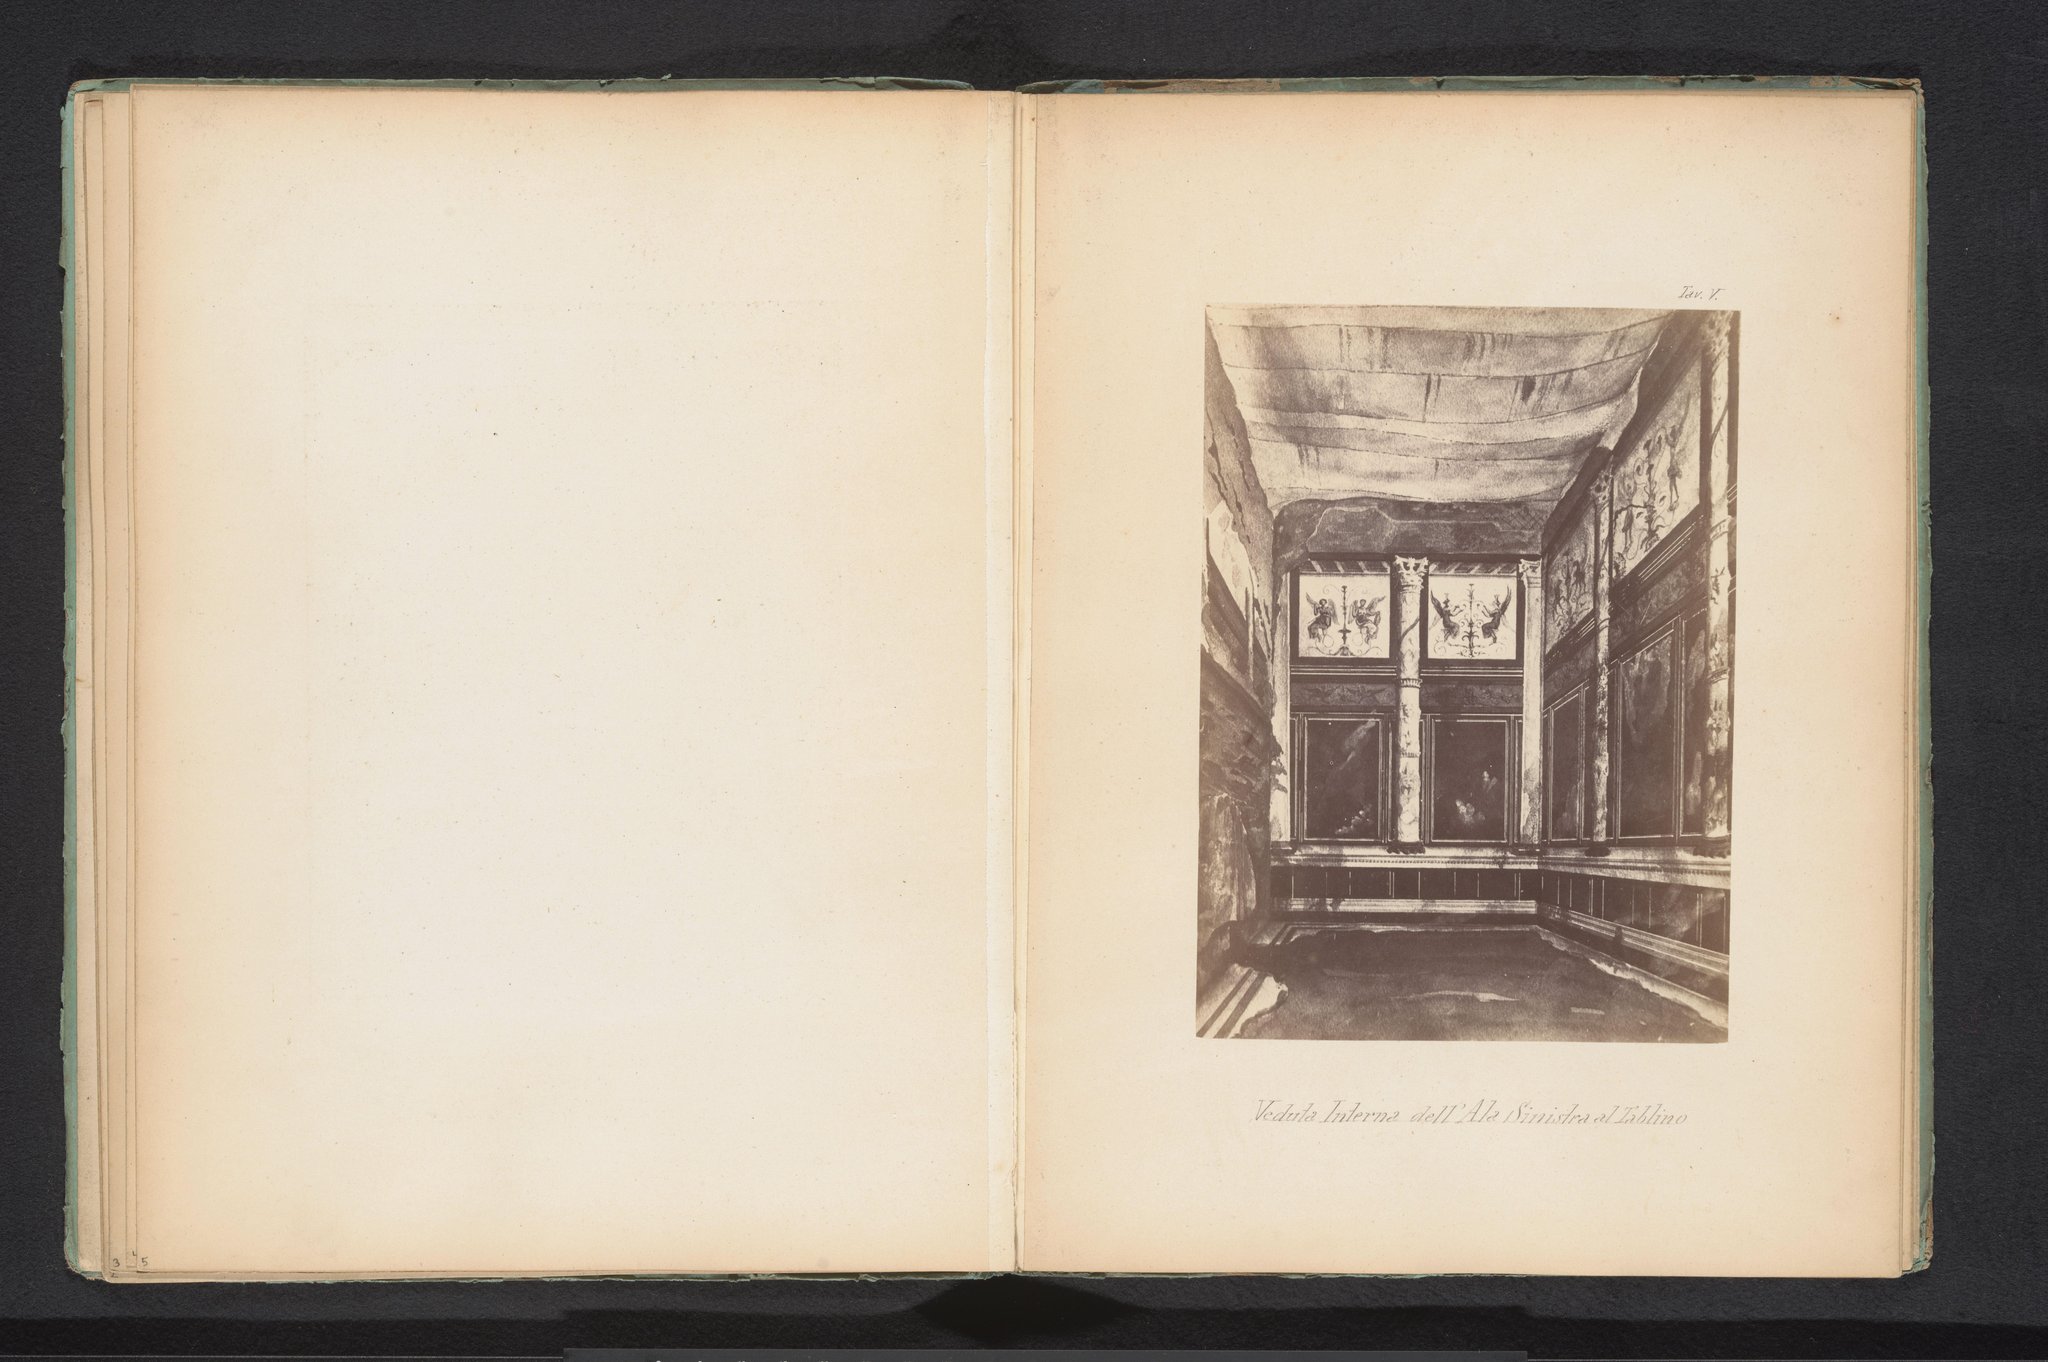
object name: reproduction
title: Veduta Interna dell'Ala Sinistra al Tablino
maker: Anonymous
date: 1859-1869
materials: photographic support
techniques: albumen print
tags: vestibule, hall, ruin of a dwelling, house, castle, etc., rome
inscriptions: number: ‘Tav. V.’